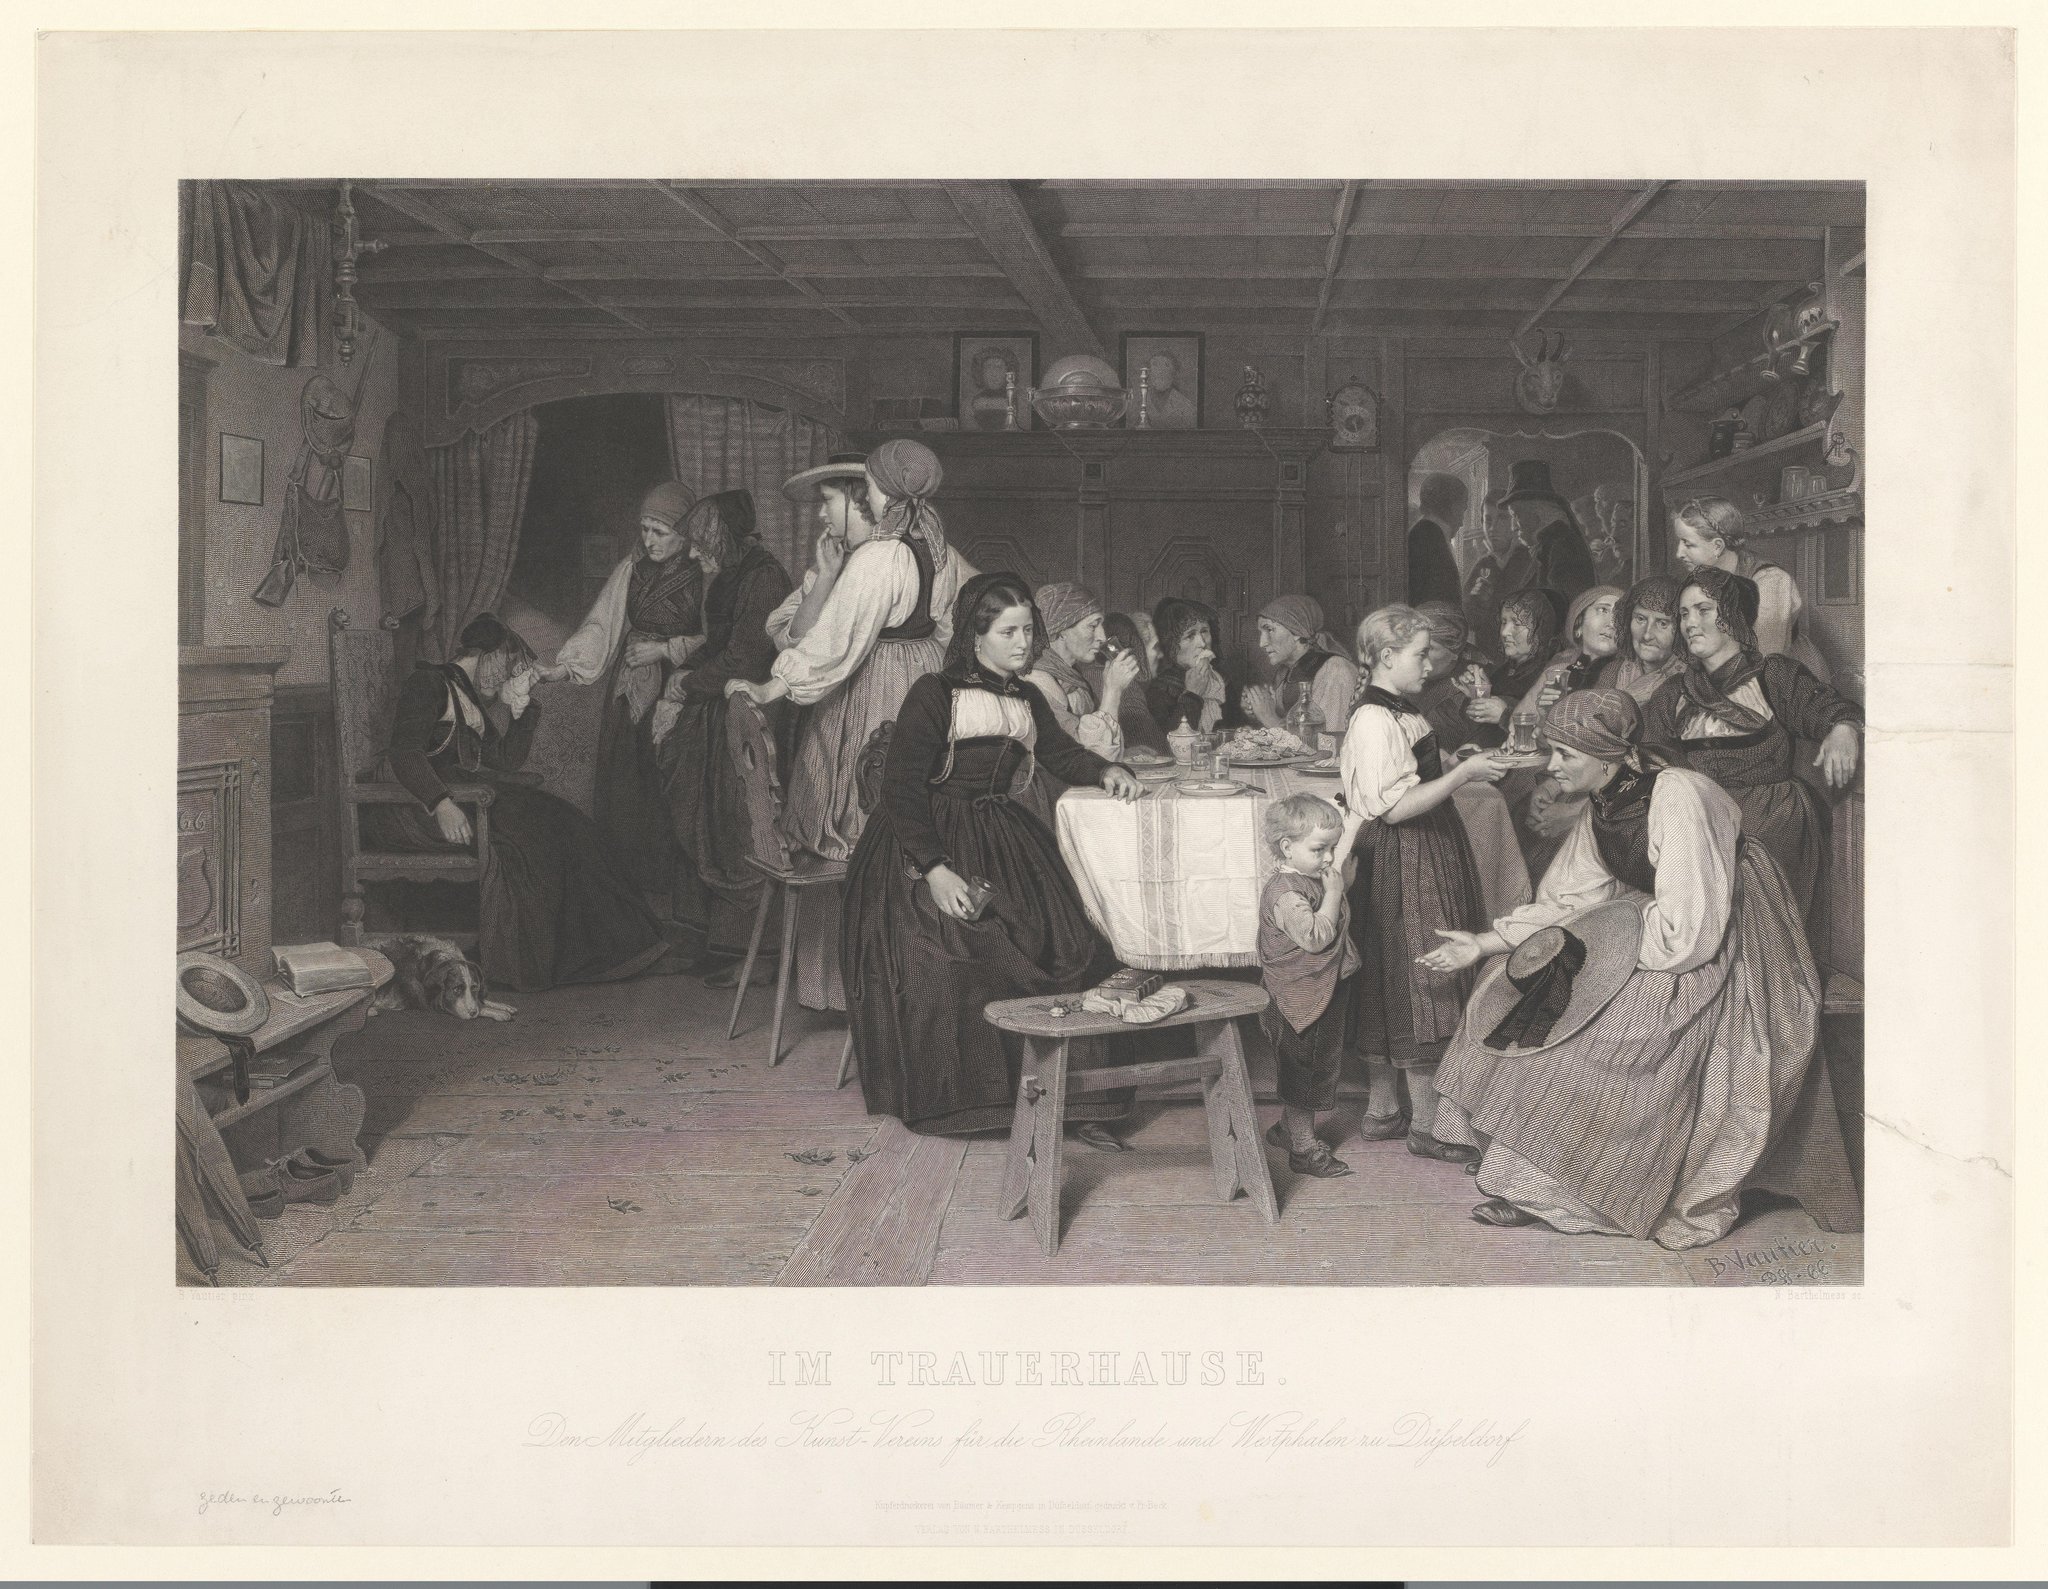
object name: print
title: Klagend gezelschap in een sterfhuis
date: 1839-1889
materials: paper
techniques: engraving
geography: dusseldorf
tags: mourning customs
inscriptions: collector's mark: Lugt 2228